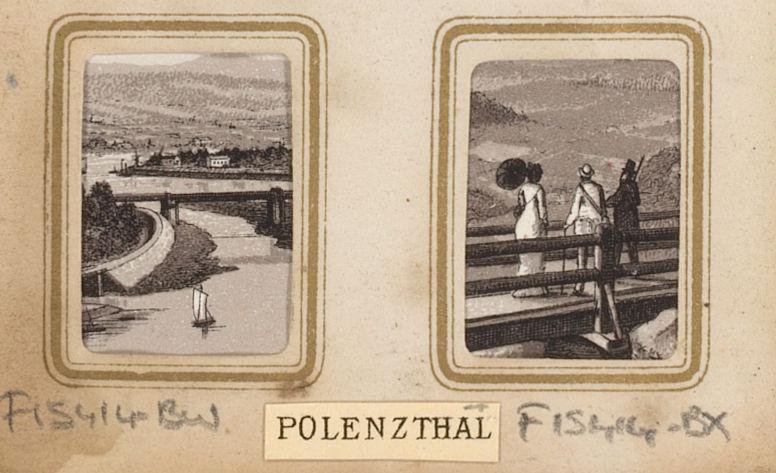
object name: print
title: Gezicht op de Polenz in Saksen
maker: Anonymous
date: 1851-1910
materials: paper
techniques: lithograph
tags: river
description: Deze prent maakt deel uit van een album.